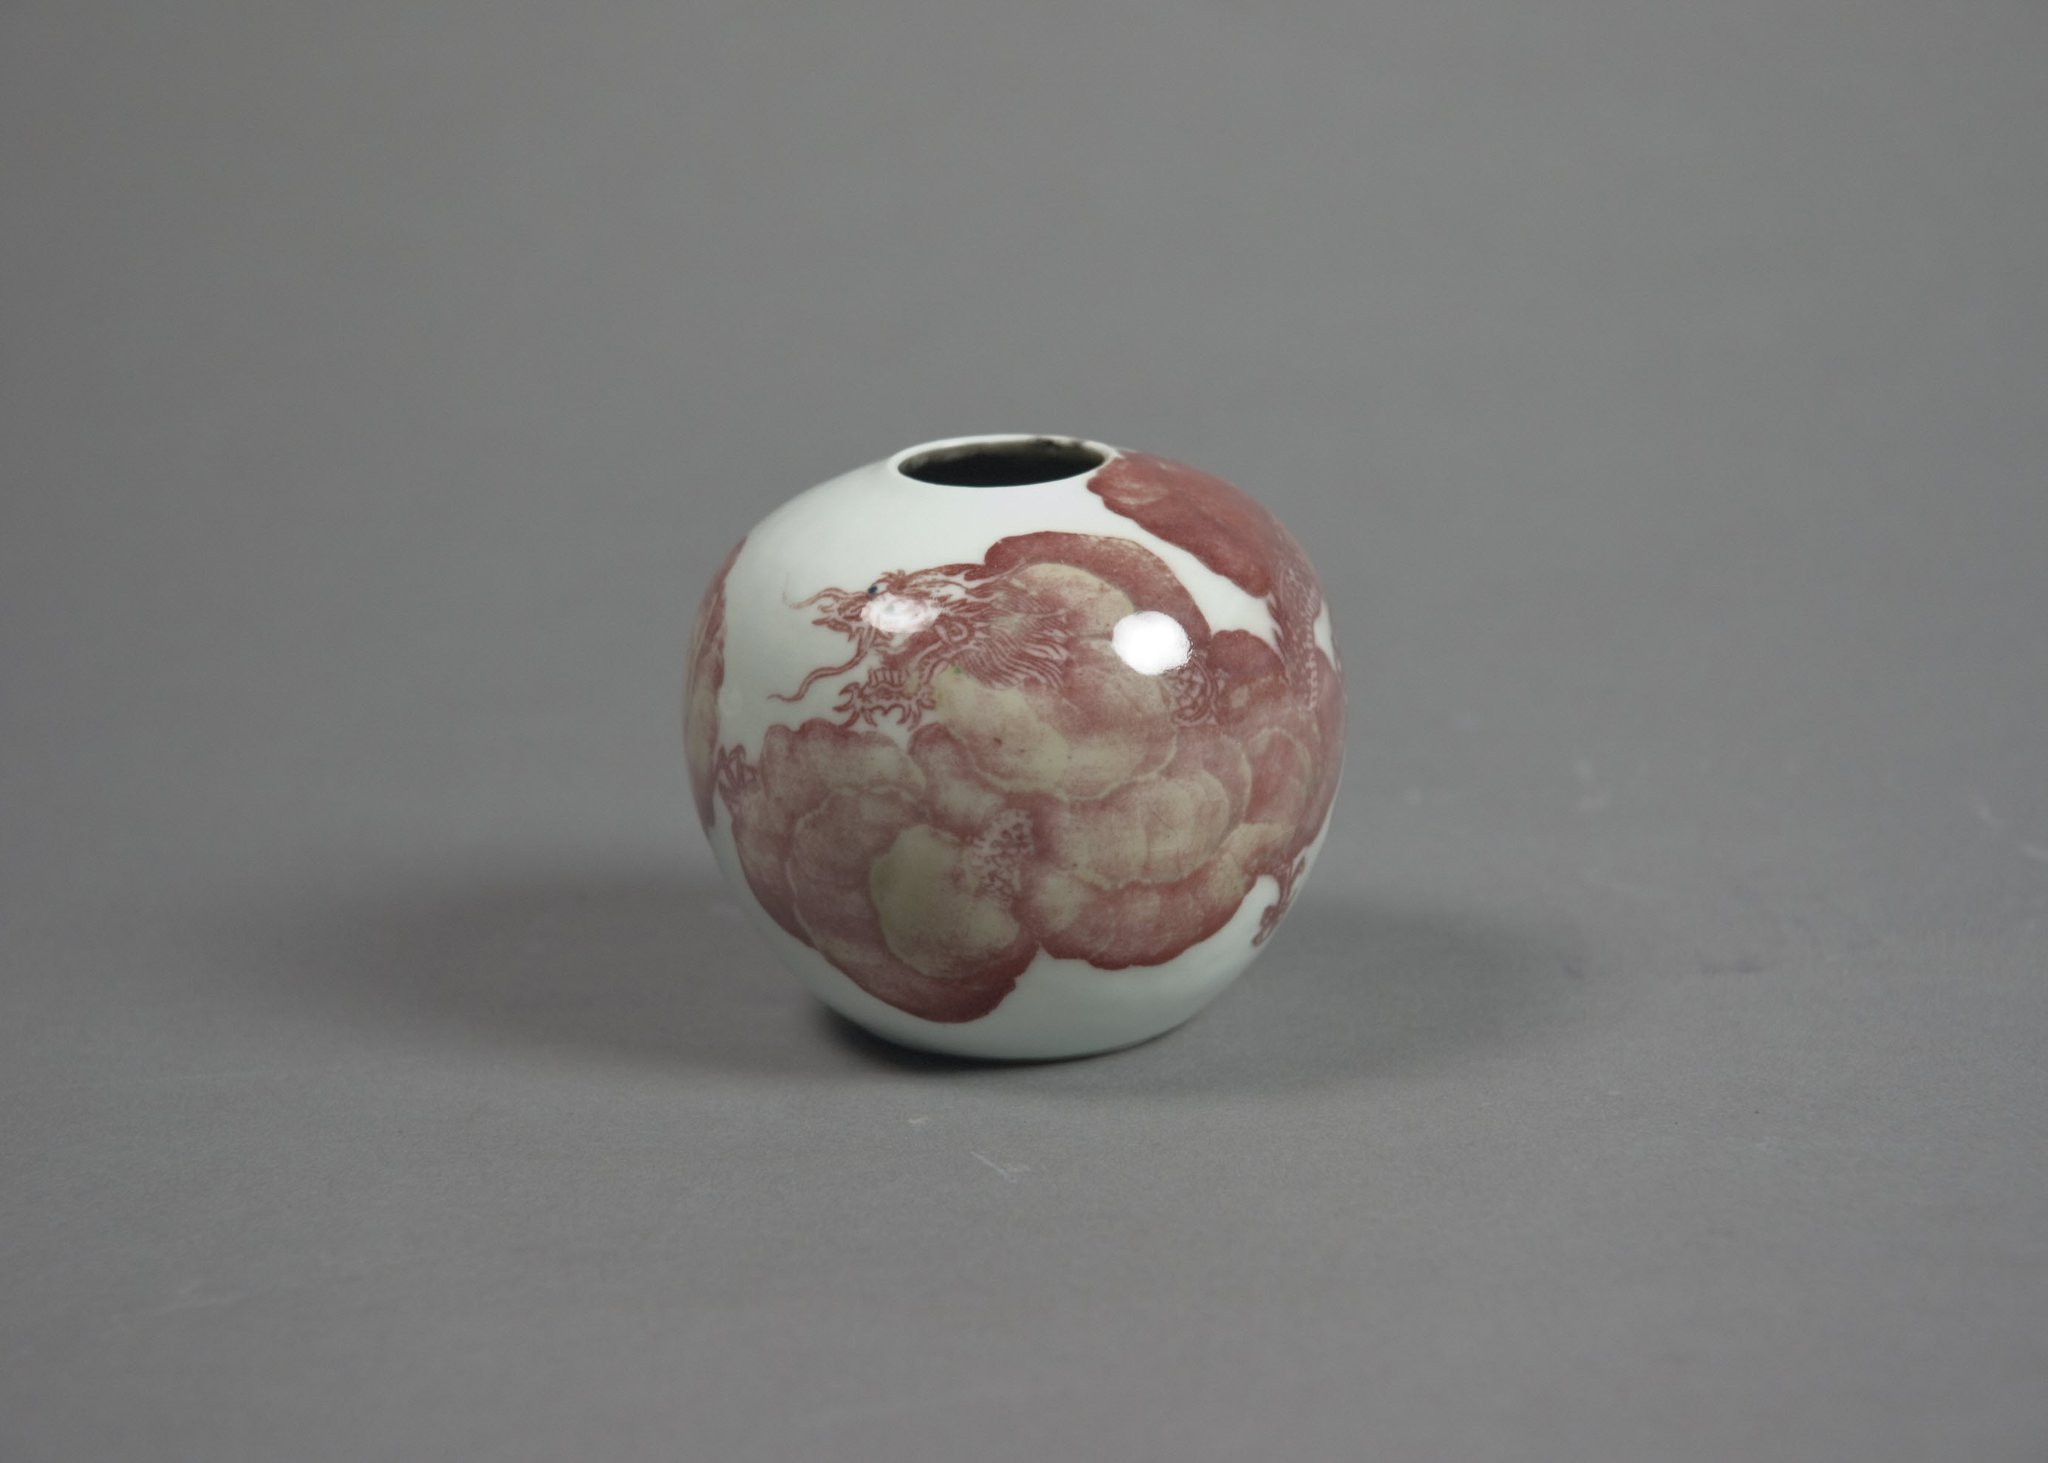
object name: water pot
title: Water pot with dragons among clouds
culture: chinese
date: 1736-1795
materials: copper, porcelain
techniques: painting, underglaze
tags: dragons